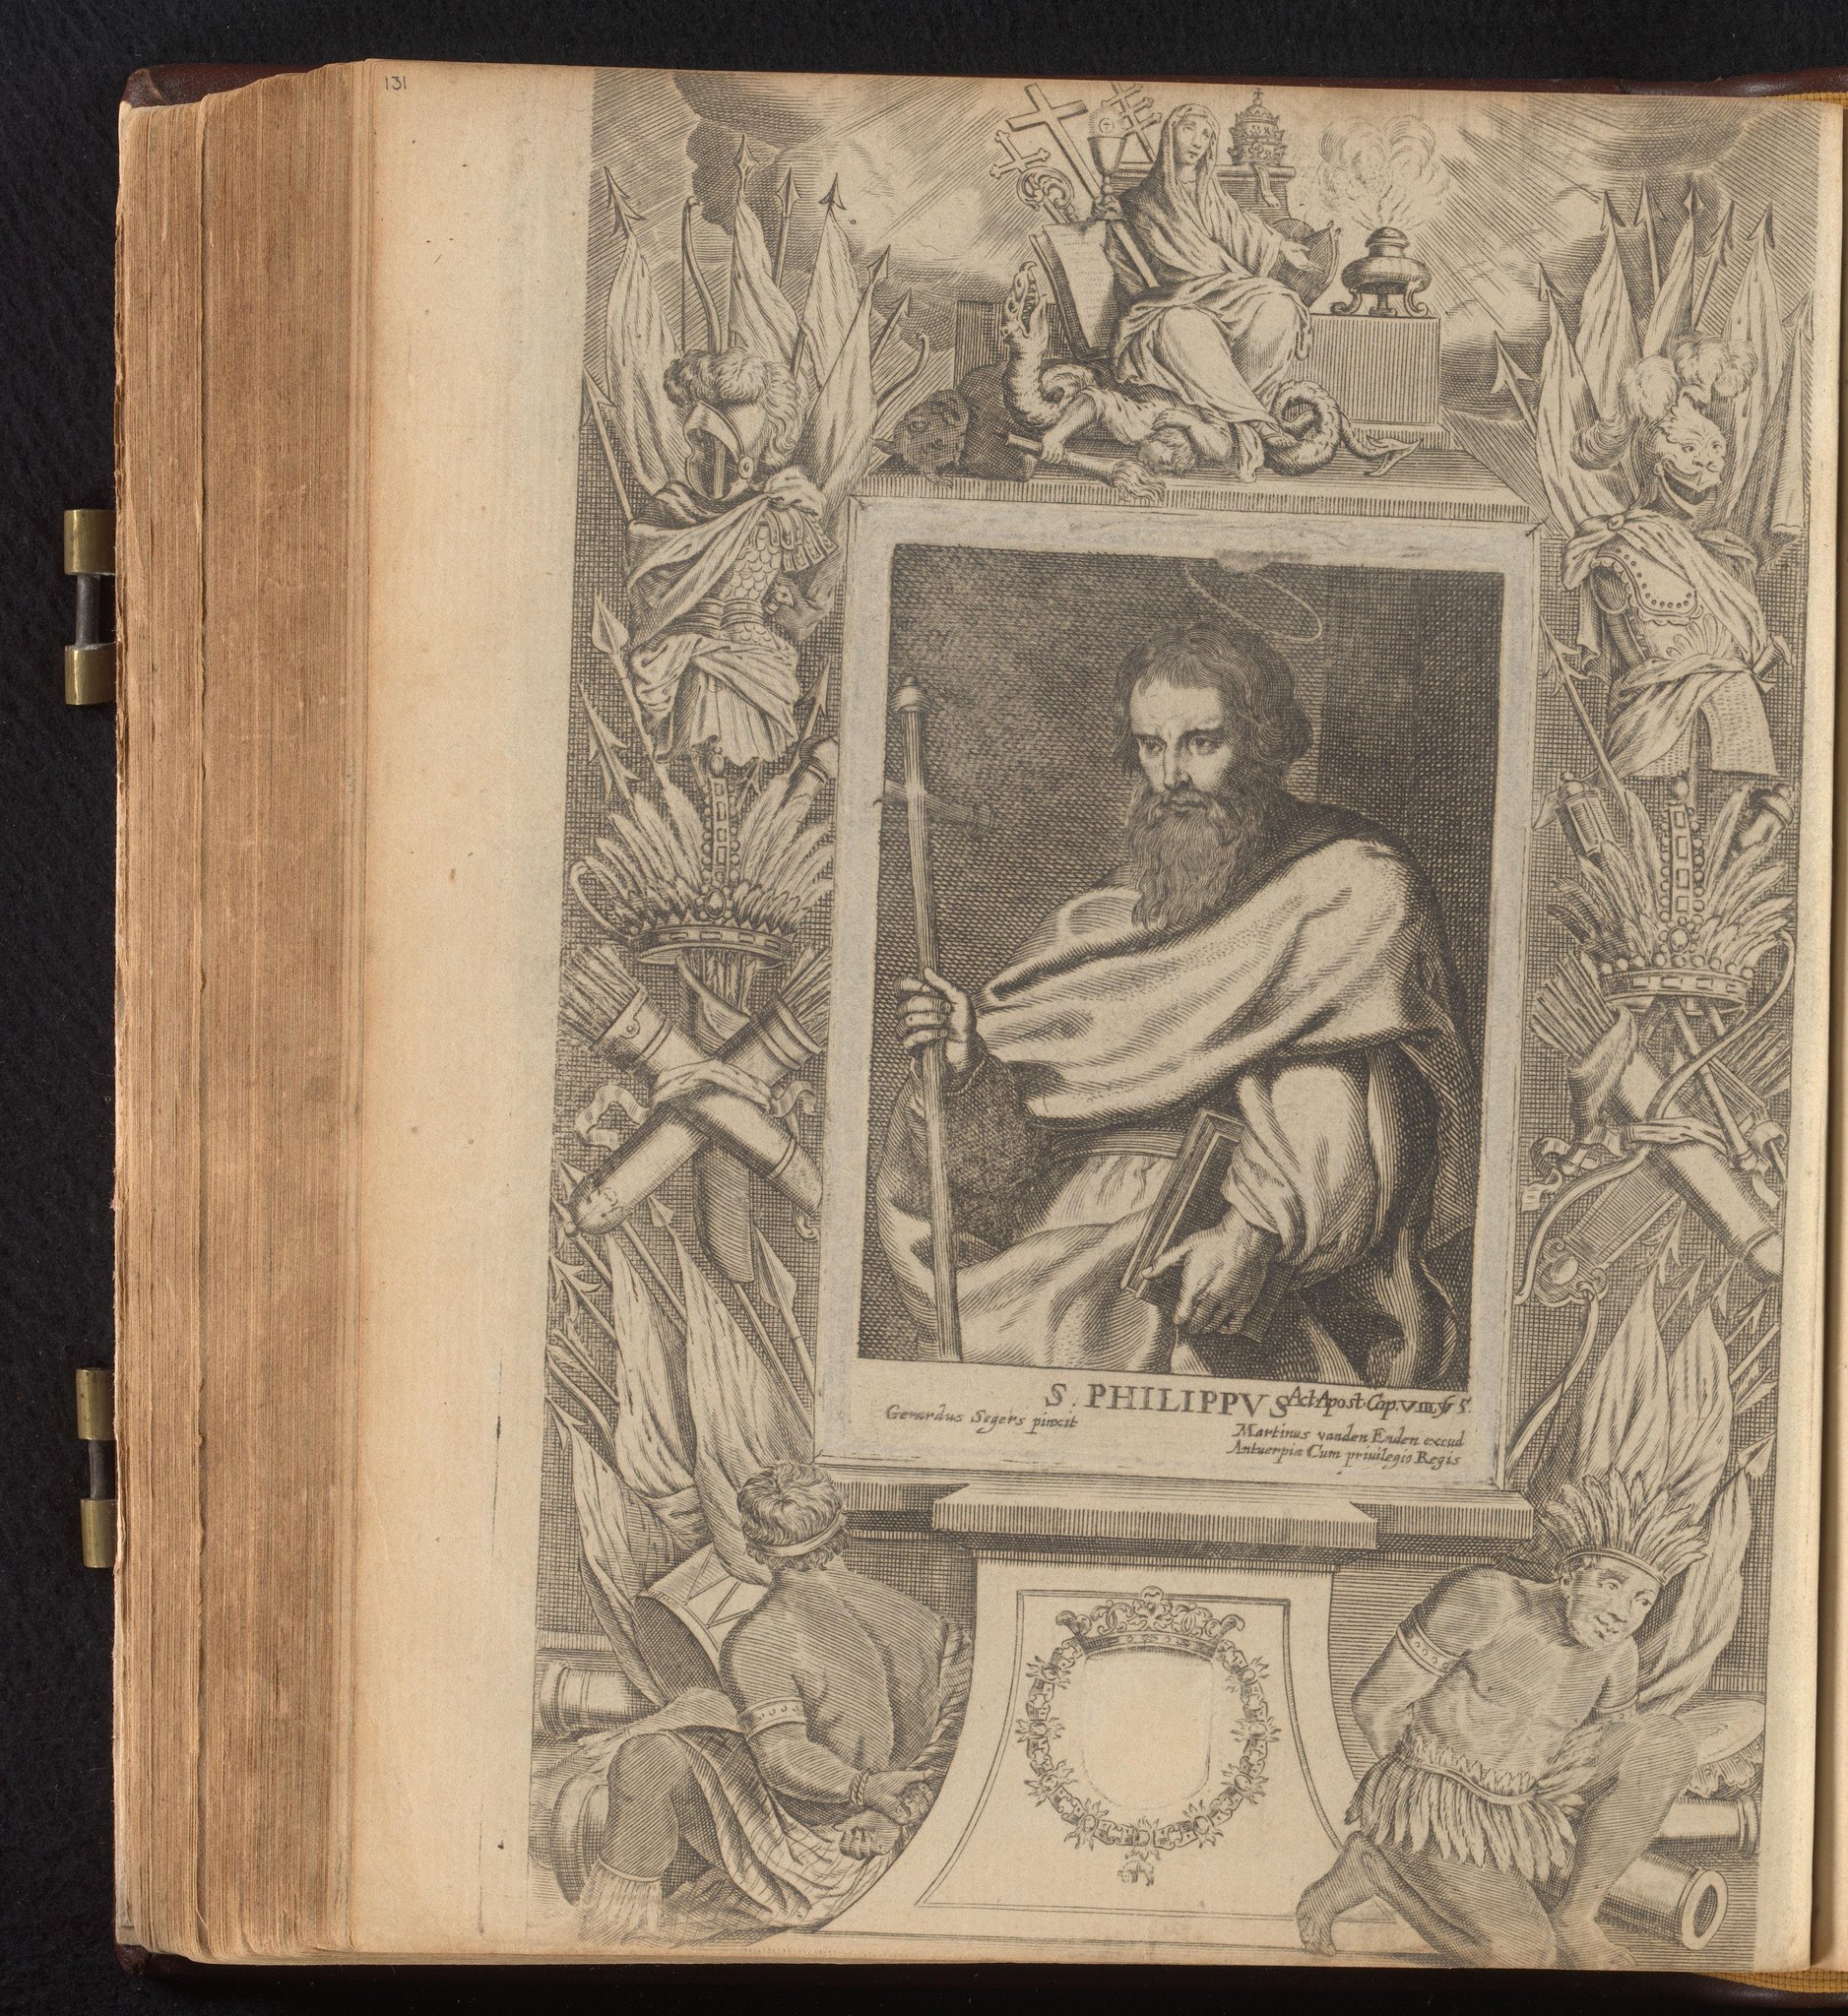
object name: print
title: Heilige Filippus met kruisstaf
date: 1783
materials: paper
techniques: engraving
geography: antwerp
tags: fides (faith) as roman personification, archer's weapons: bow and arrow, the apostle philip; possible attributes: book, cross, dish with snake, lance, scroll, stone, sword, armour, indigenous peoples of north america, armorial bearing, heraldry, smoking pot as symbol of 'vanitas'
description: Prent maakt deel uit van een prentbijbel.